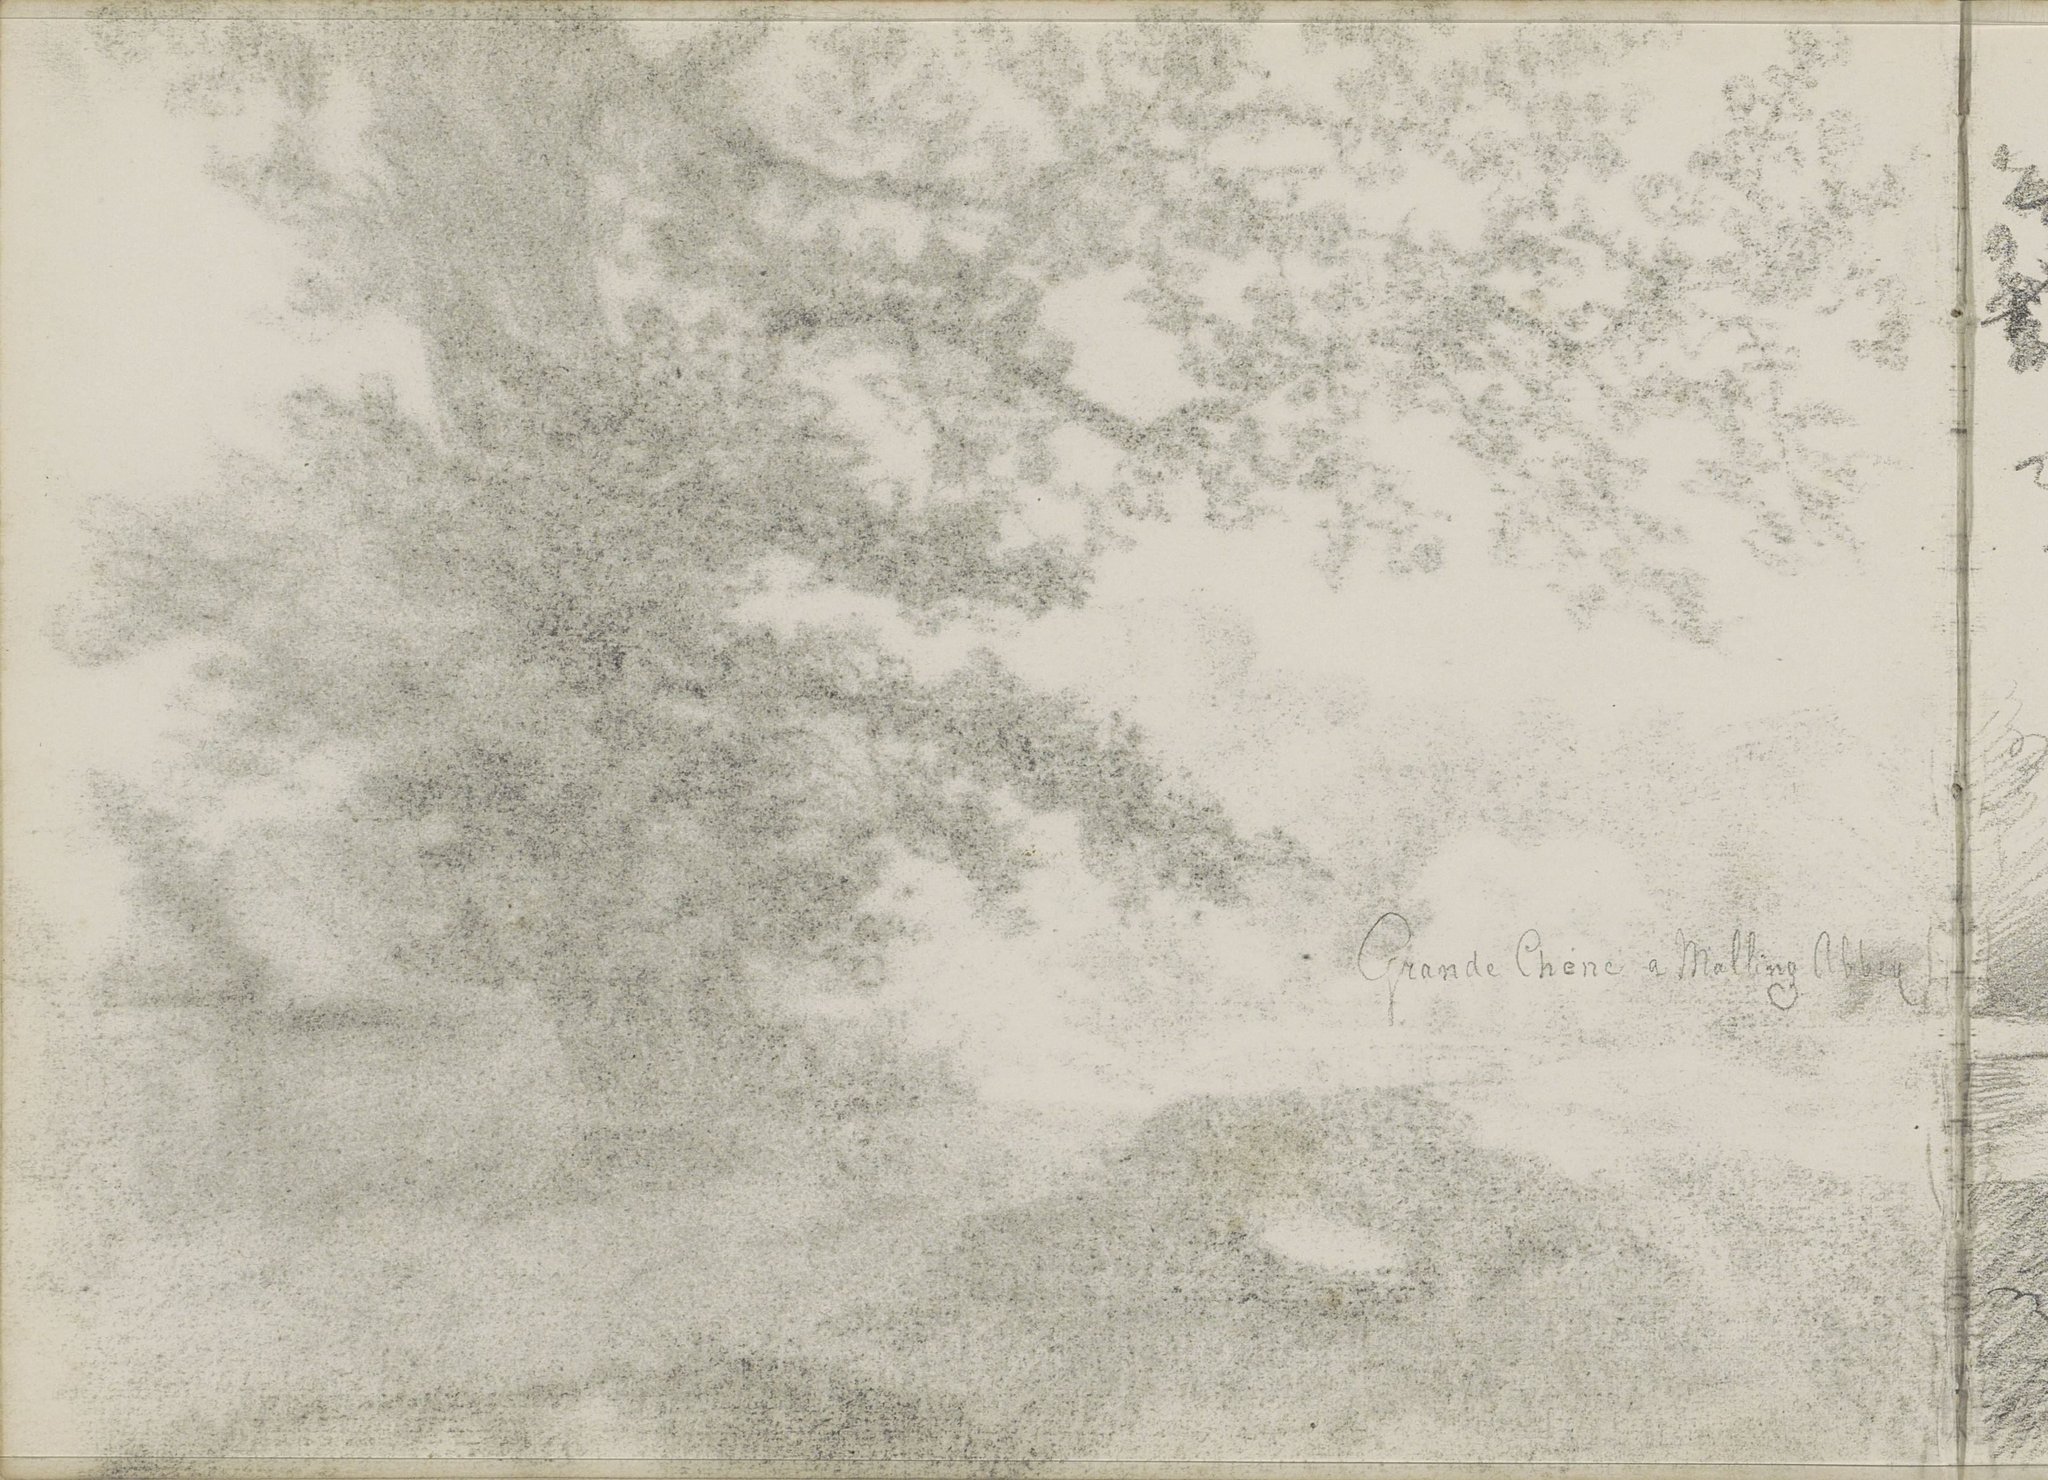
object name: sketchbook leaf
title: Notitie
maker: gerrit postma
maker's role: draughtsman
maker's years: 1819-1894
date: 1858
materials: paper, pencil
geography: west malling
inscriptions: annotation: ‘Grande Chene a Malling Abbey’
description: Blad 22 verso uit een schetsboek met 52 bladen.